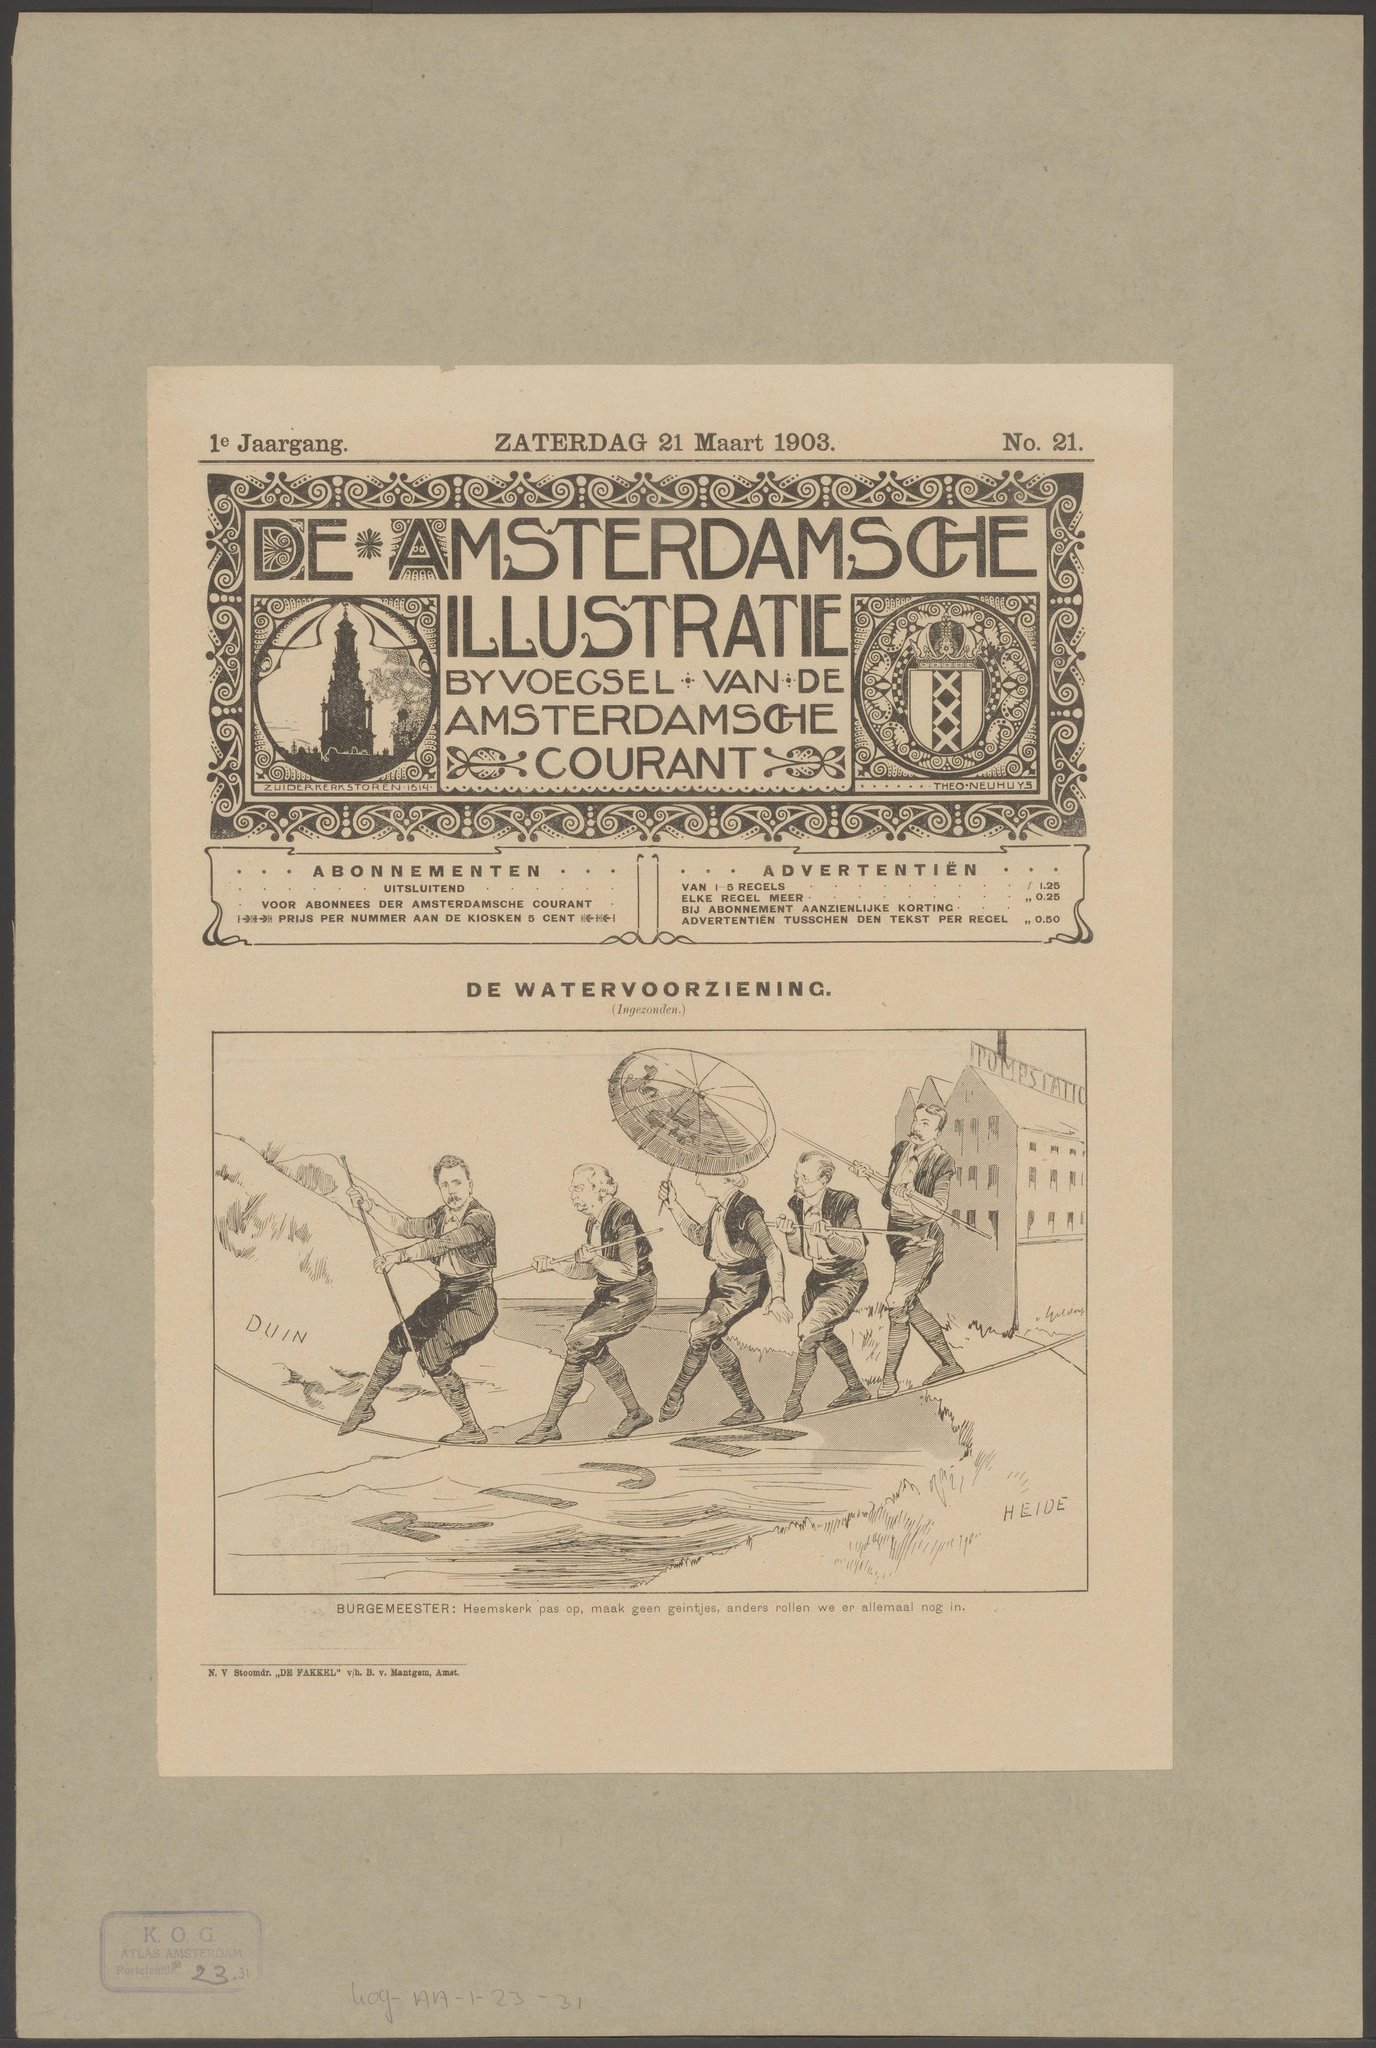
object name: cartoon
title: Amsterdamse politici balanceren op een koord over de Rijn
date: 1903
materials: paper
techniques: letterpress printing, line block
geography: netherlands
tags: utrecht, surabaya, the hague, mayor, coat of arms (as symbol of the state, etc.) (+ city; municipal), water-supply (~ public services), tight-ropewalker, parasol, sunshade, political caricatures and satires, parts of church exterior and annexes: tower, amsterdam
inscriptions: collector's mark: Lugt 1641b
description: Gepubliceerd als bijvoegsel van 'De Amsterdamsche Courant', 21 maart 1903.